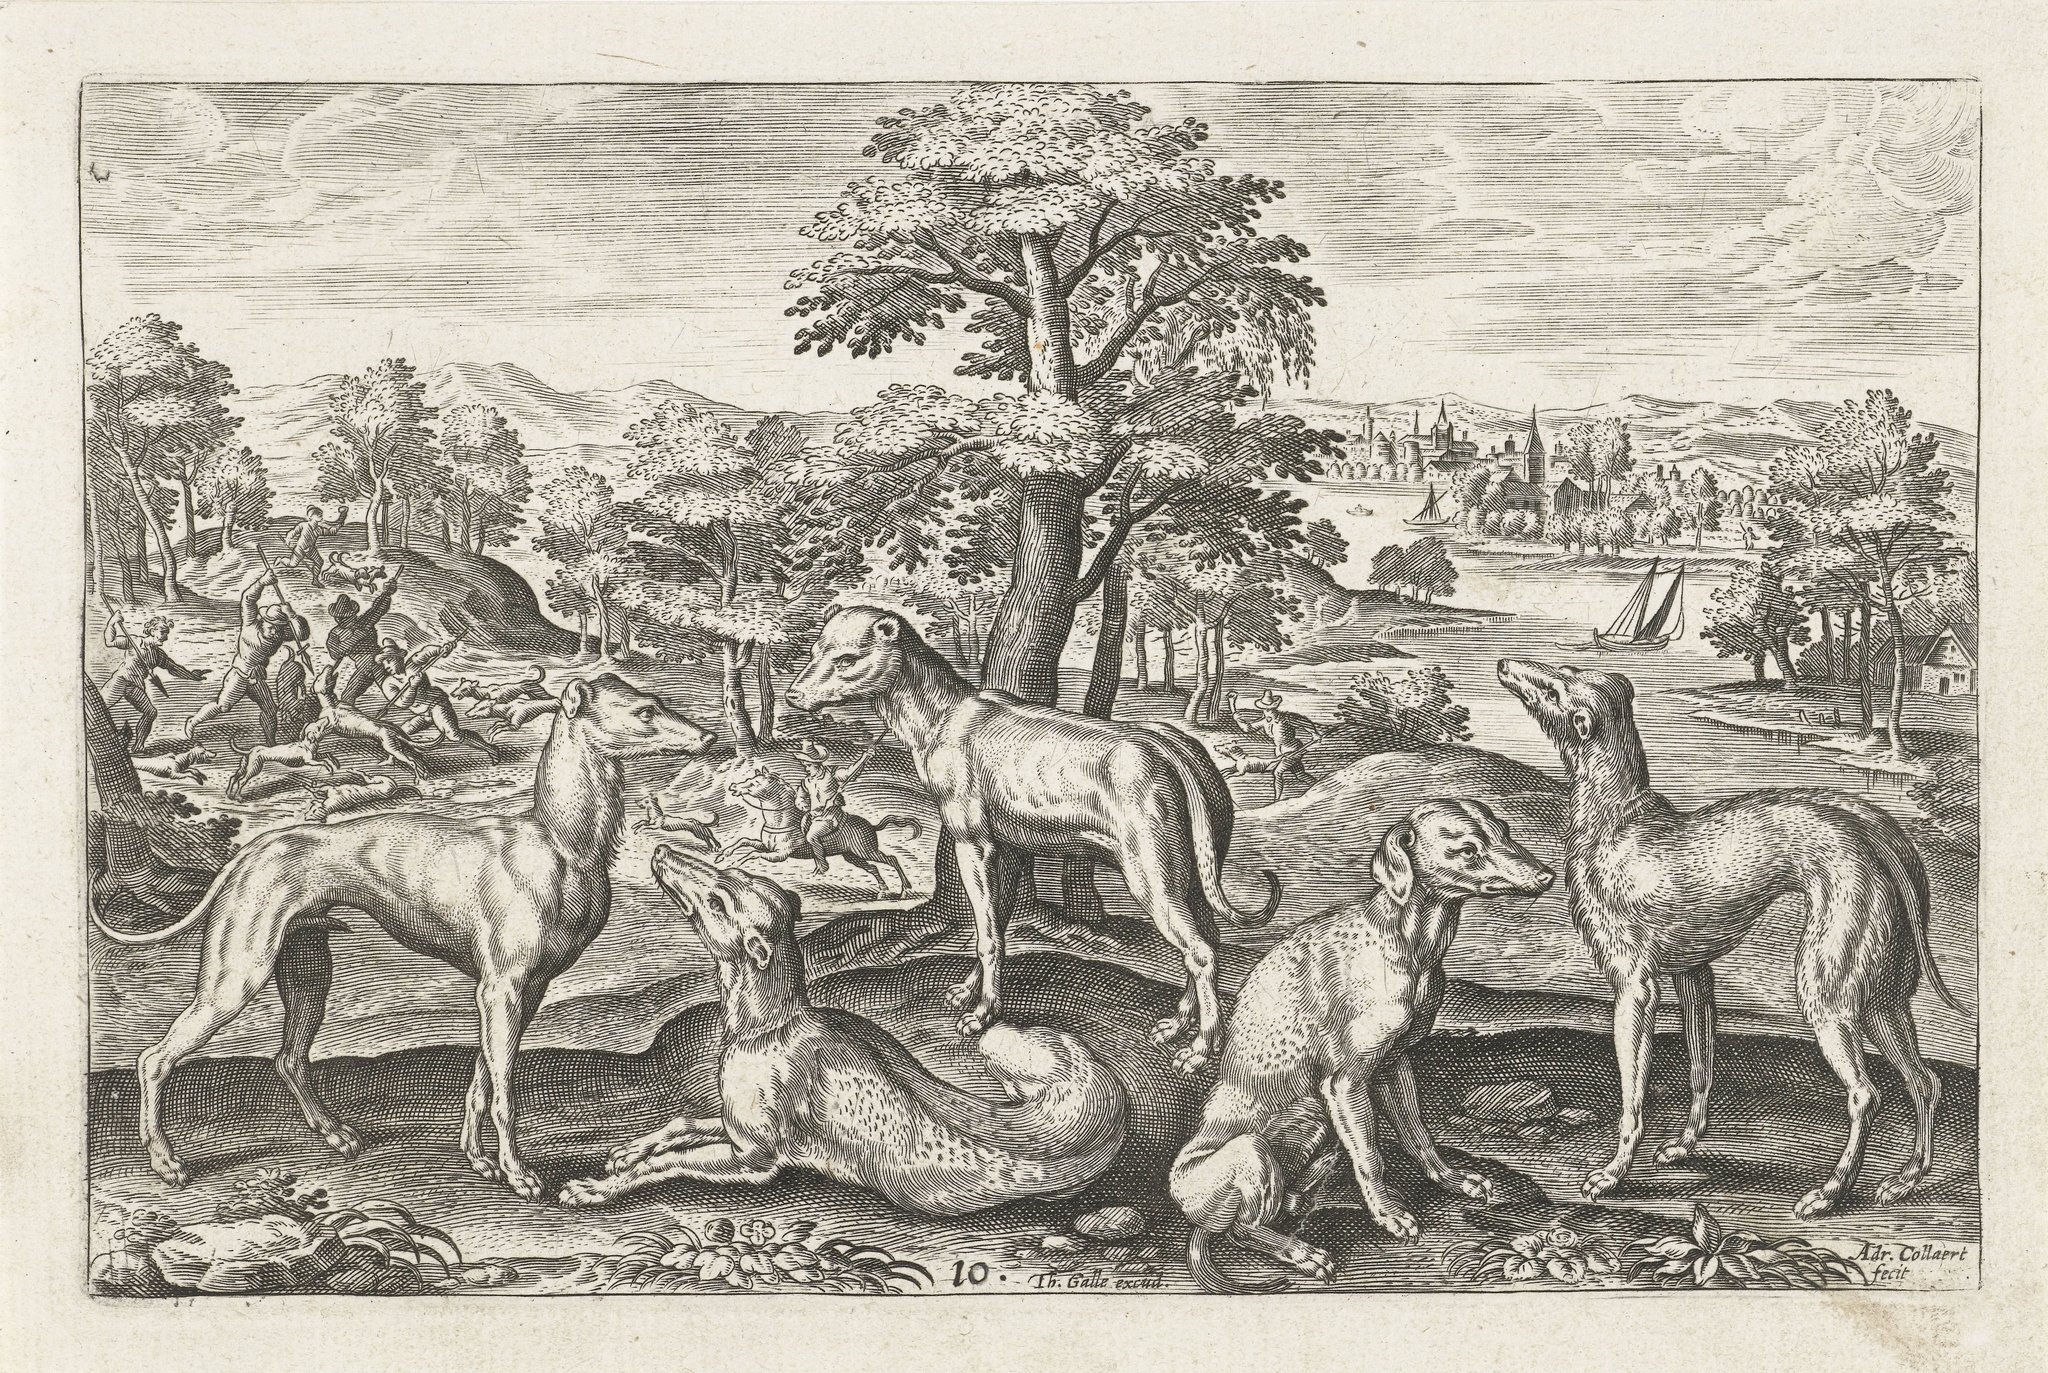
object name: print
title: Jachthonden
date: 1595-1633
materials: paper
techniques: engraving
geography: antwerp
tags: hunting dogs, river, hunt ~ predatory animals (fox, lion)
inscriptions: collector's mark: Lugt 2228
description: Op de voorgrond vijf jachthonden. Op de achtergrond een landschap met een rivier en een wolvenjacht. De prent maakt deel uit van een serie met dieren als onderwerp.